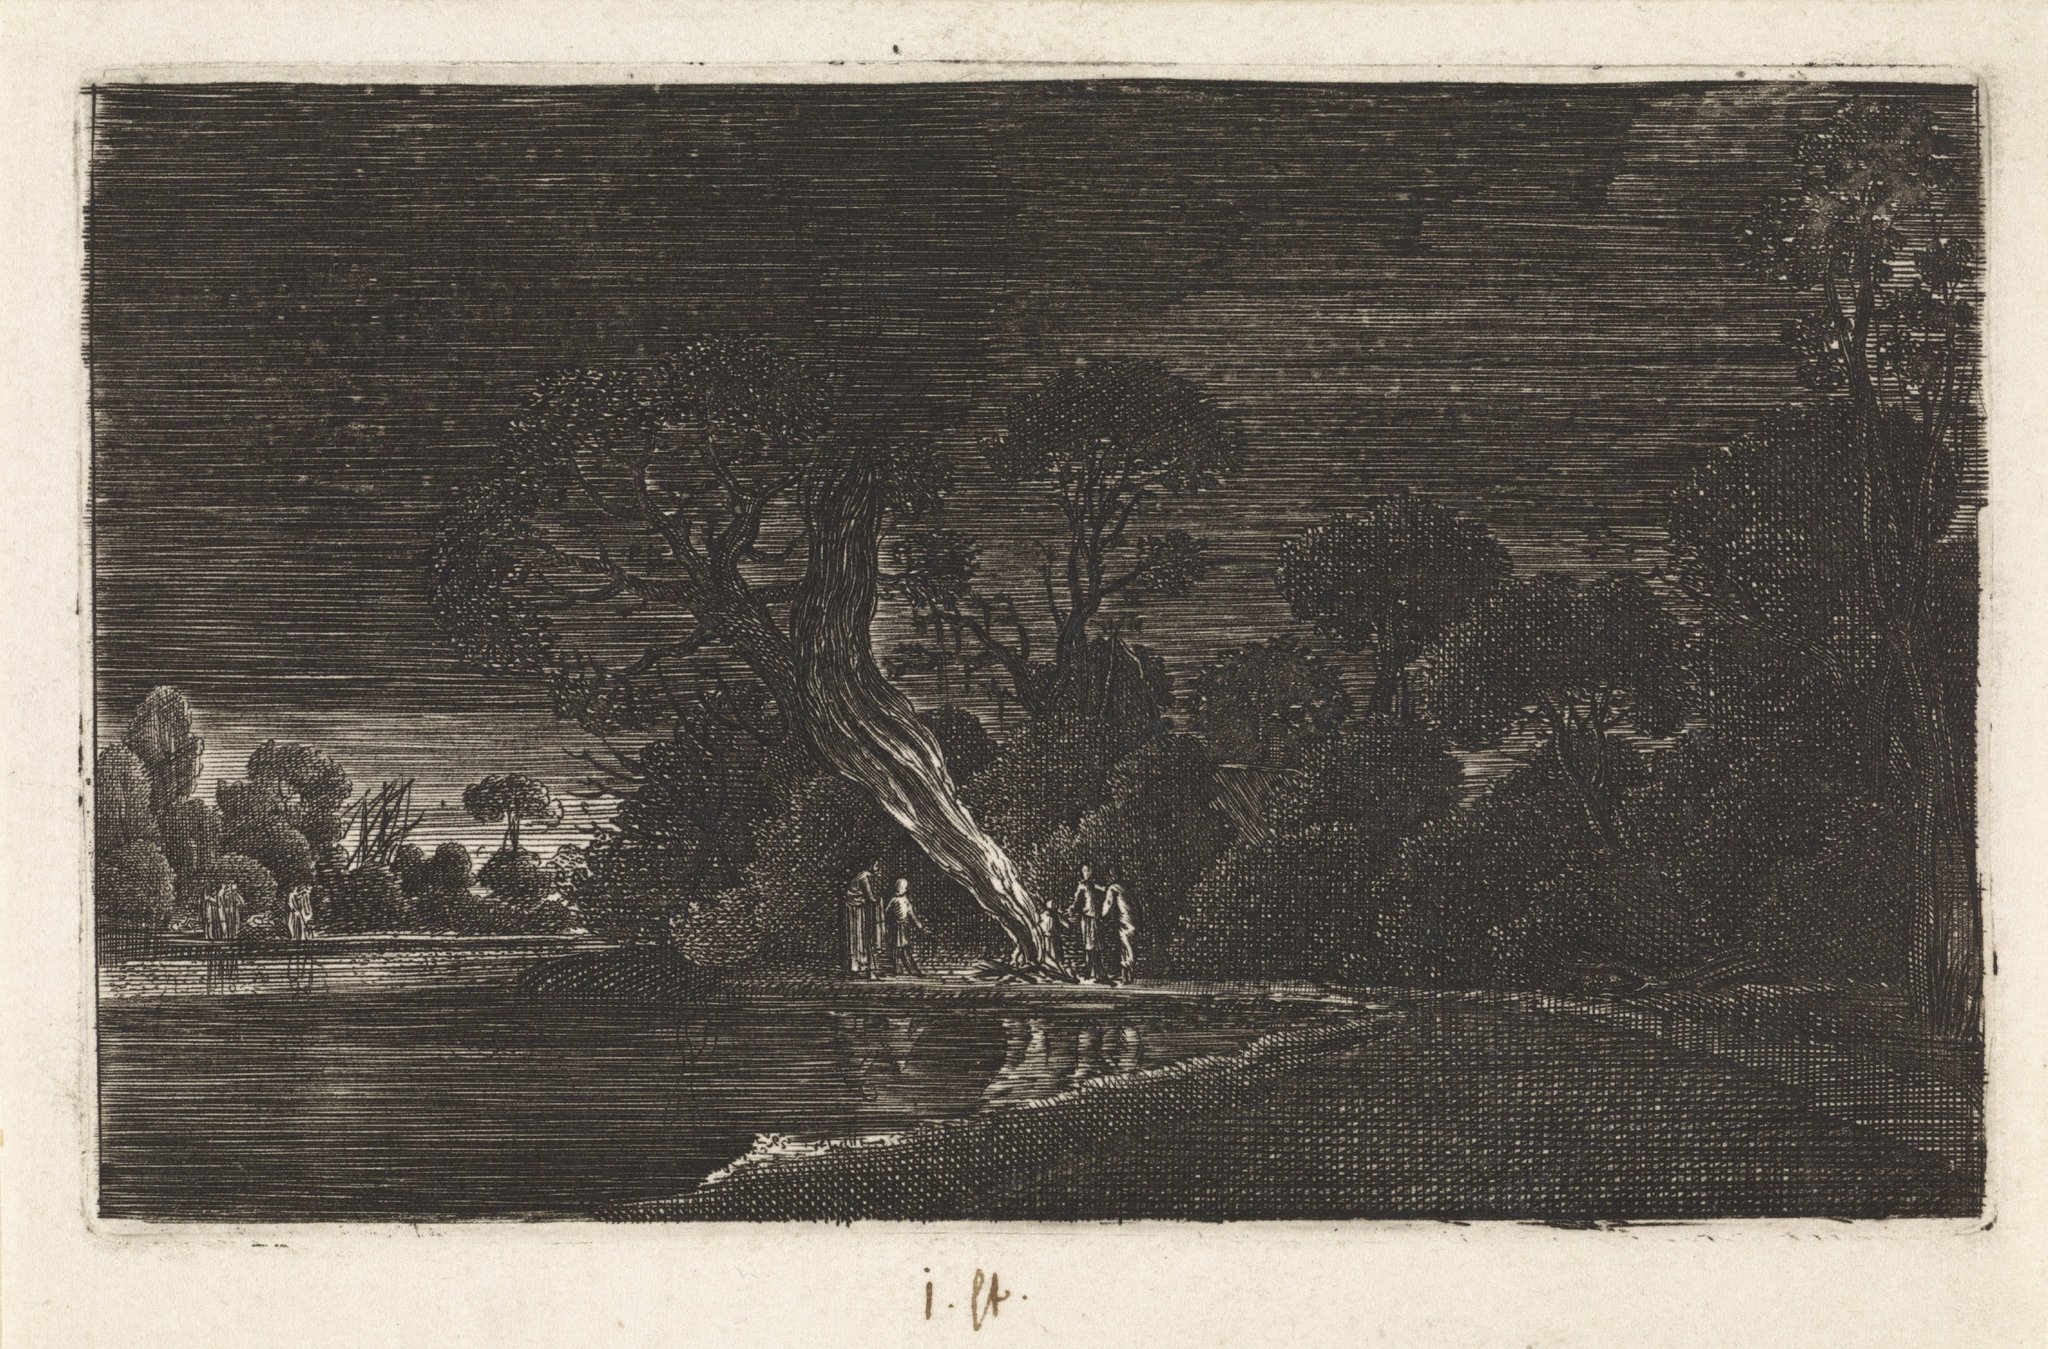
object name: print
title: Landschap bij maanlicht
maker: jan van de velde (ii)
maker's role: draughtsman, painter, print maker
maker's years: 1593-1641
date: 1603-1641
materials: paper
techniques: engraving, etching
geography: northern netherlands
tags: river, moonlight, night ~ landscape (sometimes titled 'nox')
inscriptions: caption: ‘i.lt.’, collector's mark: Lugt 2228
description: Nachtlandschap met een rivier. Op de rechteroever, onder een boom, enkele figuren in maanlicht.